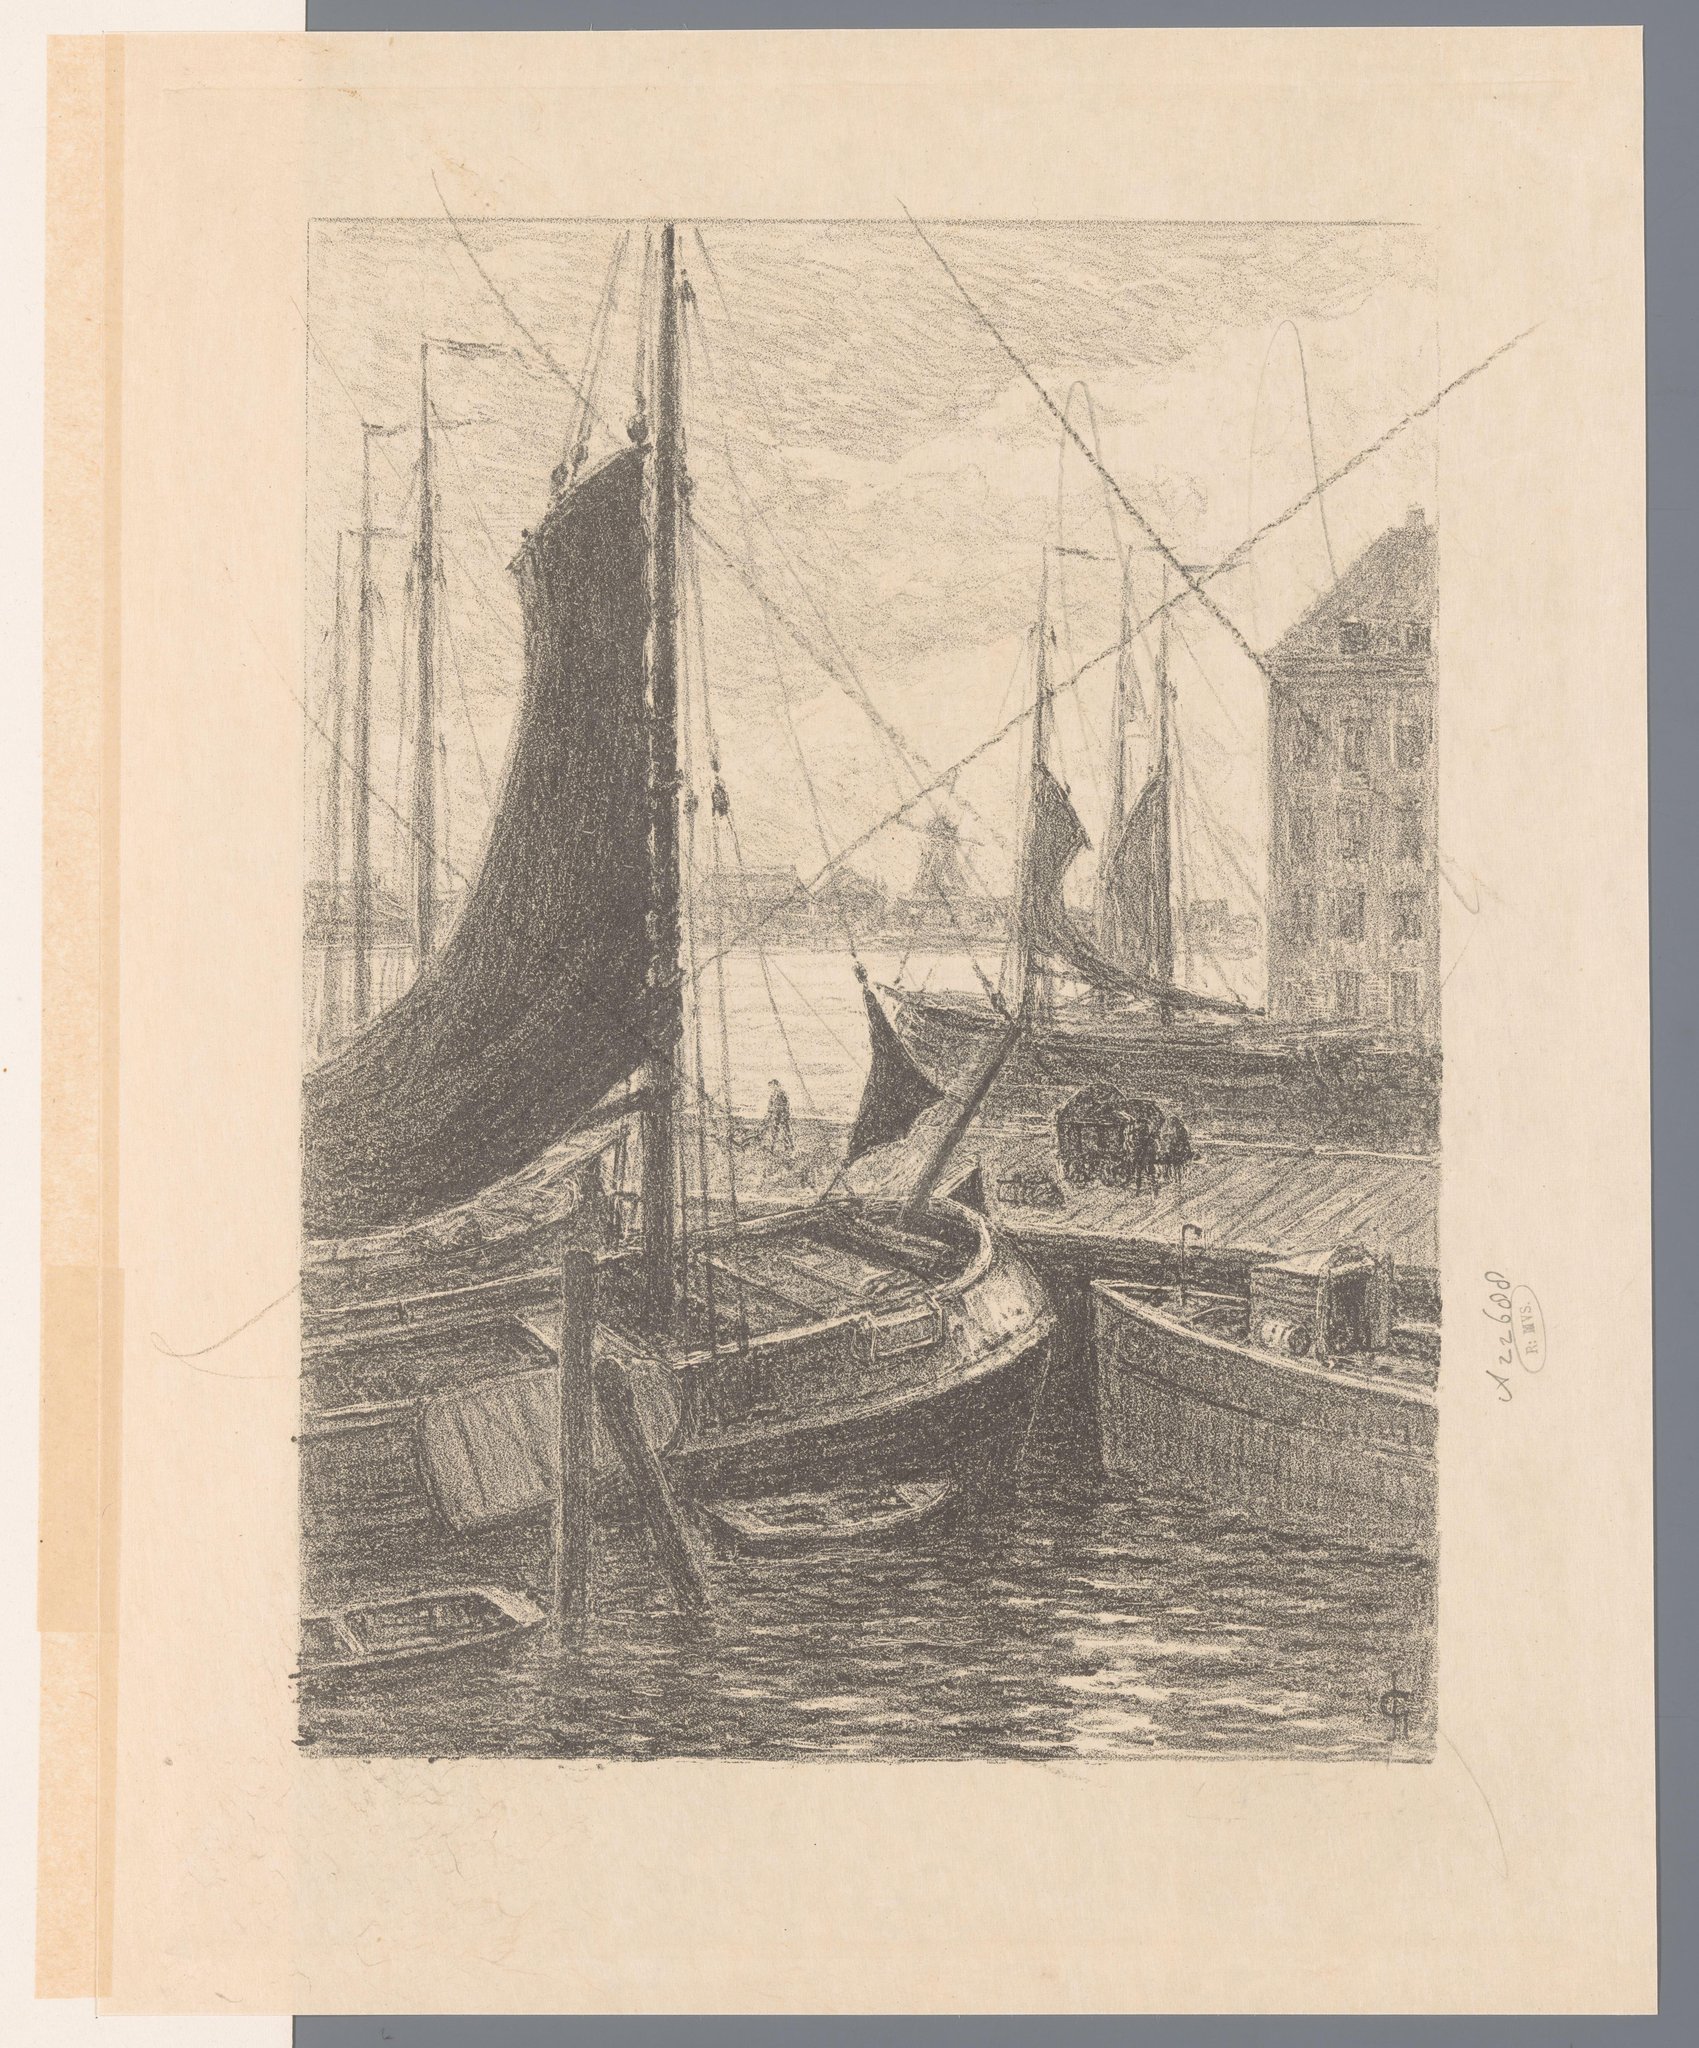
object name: print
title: Havengezicht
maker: carel nicolaas storm van s-gravesande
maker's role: draughtsman, print maker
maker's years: 1841-1924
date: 1851-1902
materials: paper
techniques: lithograph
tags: harbour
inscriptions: collector's mark: Lugt 2228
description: Mogelijk vermeld in: Storm van 's-Gravesande, Charles. Catalogue des eaux-fortes et lithographies. New York: s.n., 1903, of in een onbekende latere uitgave van het manuscript. Vermoedelijk vermeld als catalogusnummer 7.